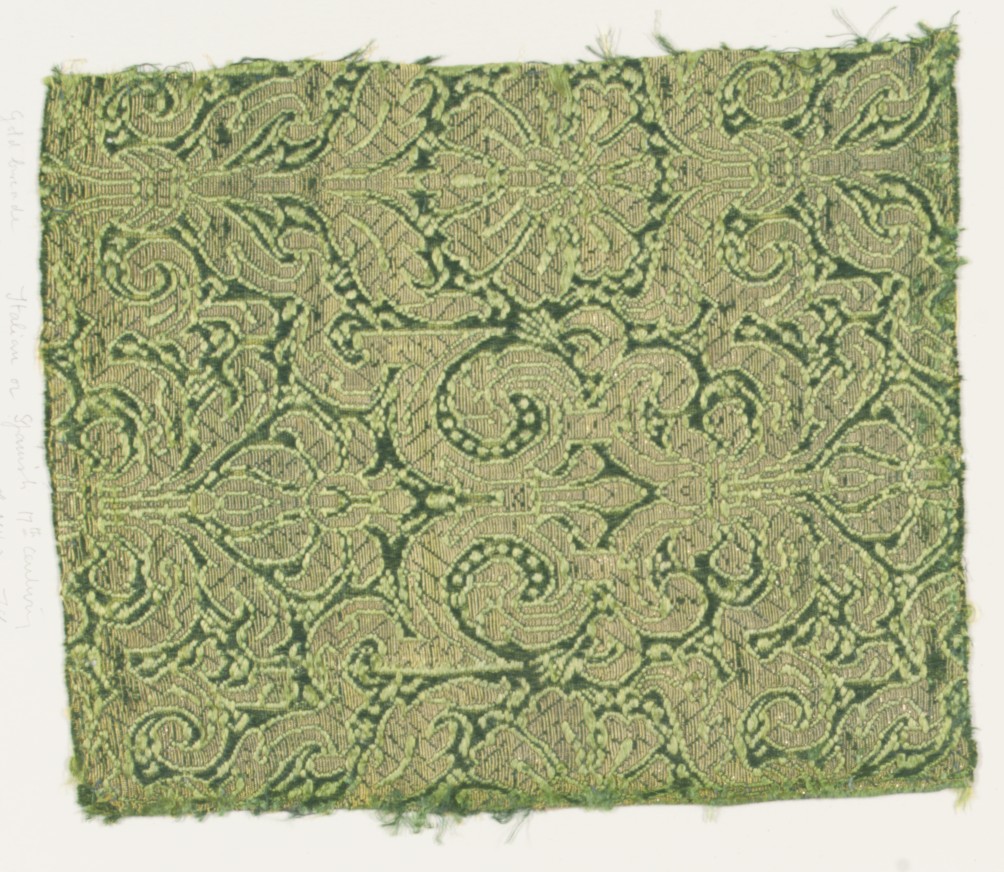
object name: fragment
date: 1601-1700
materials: metal thread, silk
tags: flowers,leaves